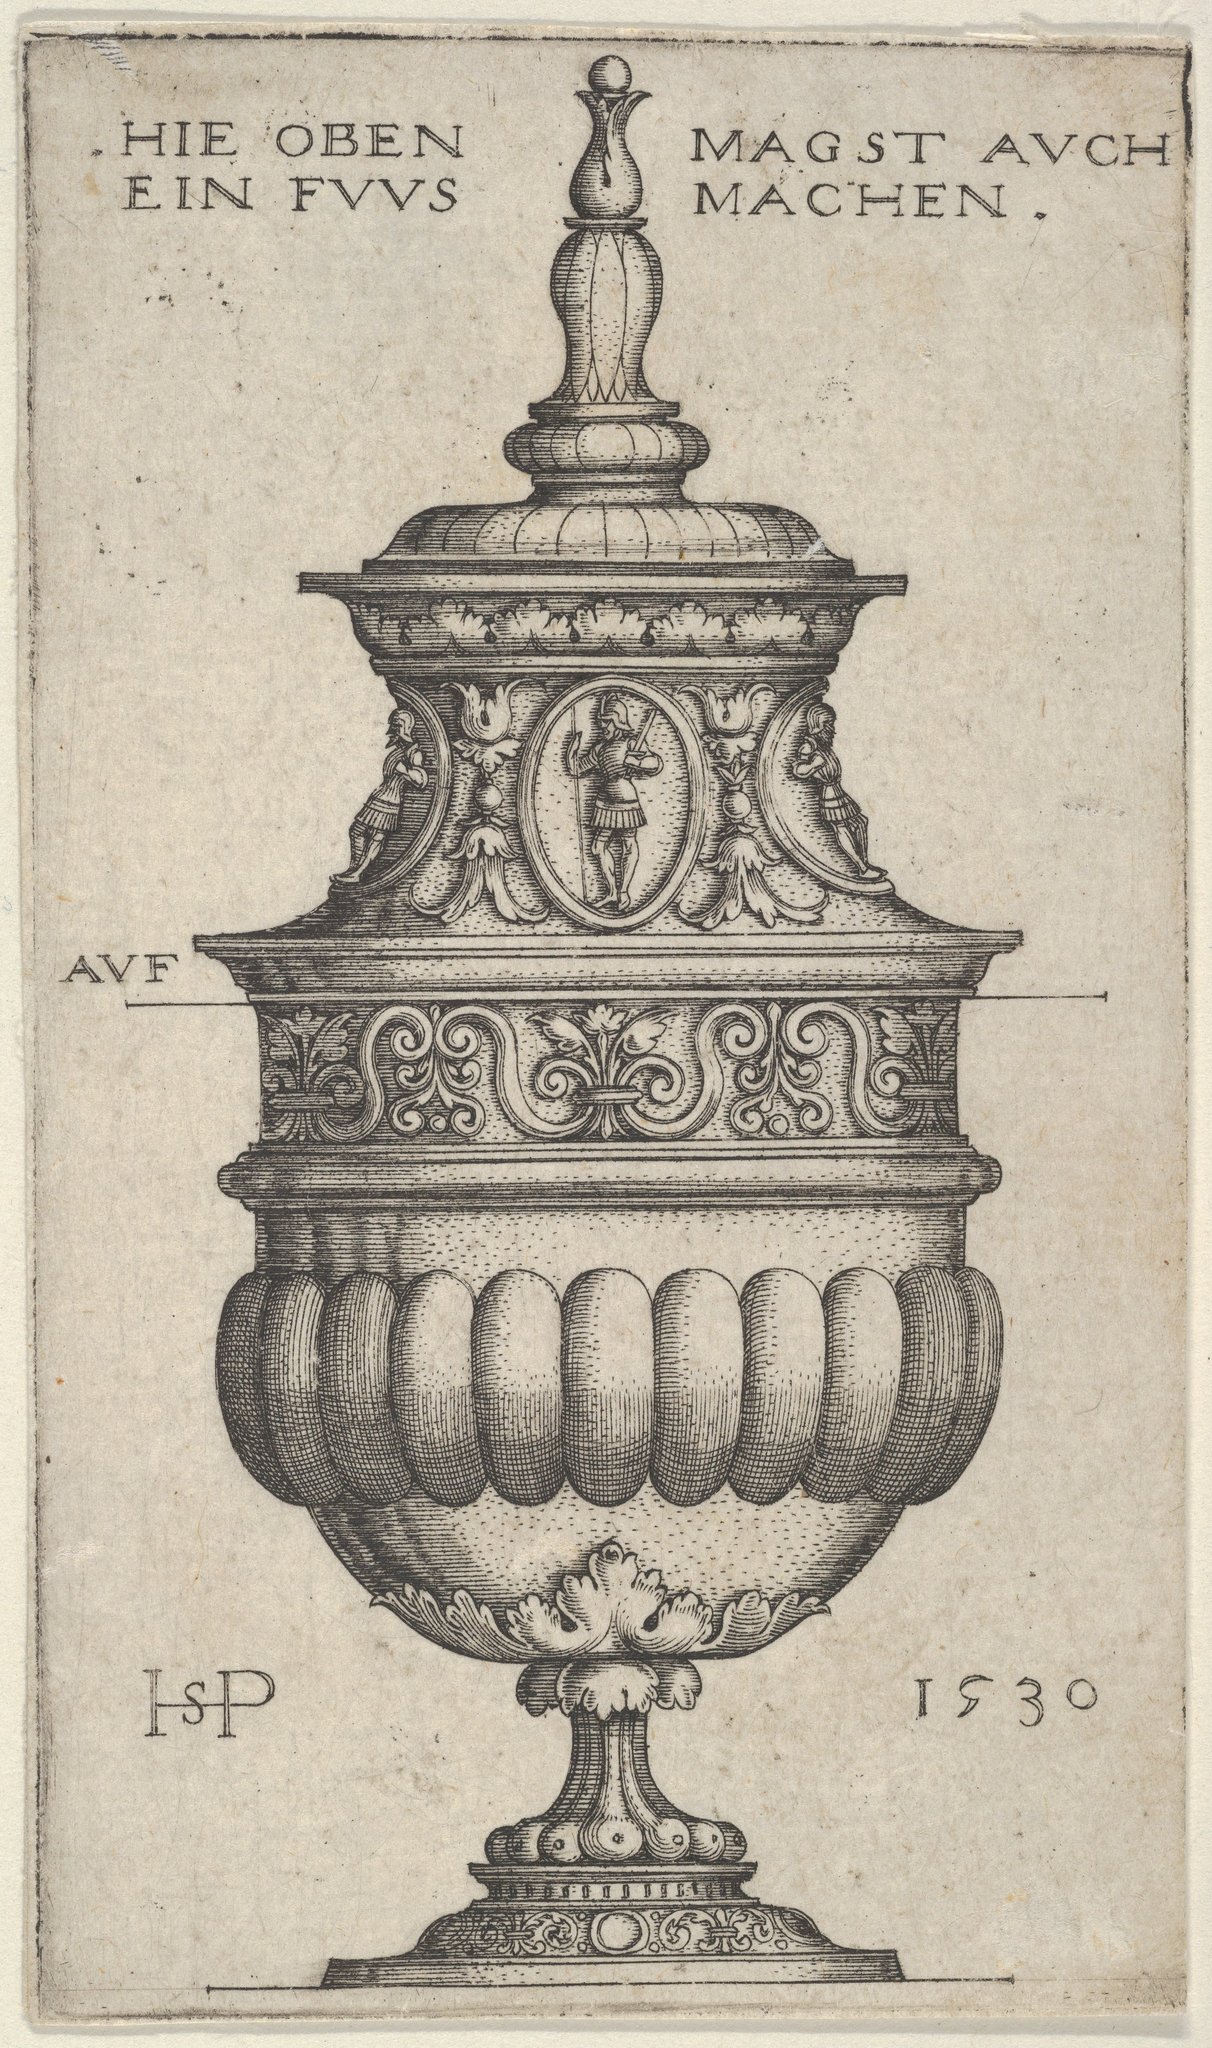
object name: print ornament architecture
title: Double Goblet with Oval Medallions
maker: sebald beham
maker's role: artist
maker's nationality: german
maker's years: 1500-1550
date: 1530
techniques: engraving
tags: medallions,men,drinking glasses